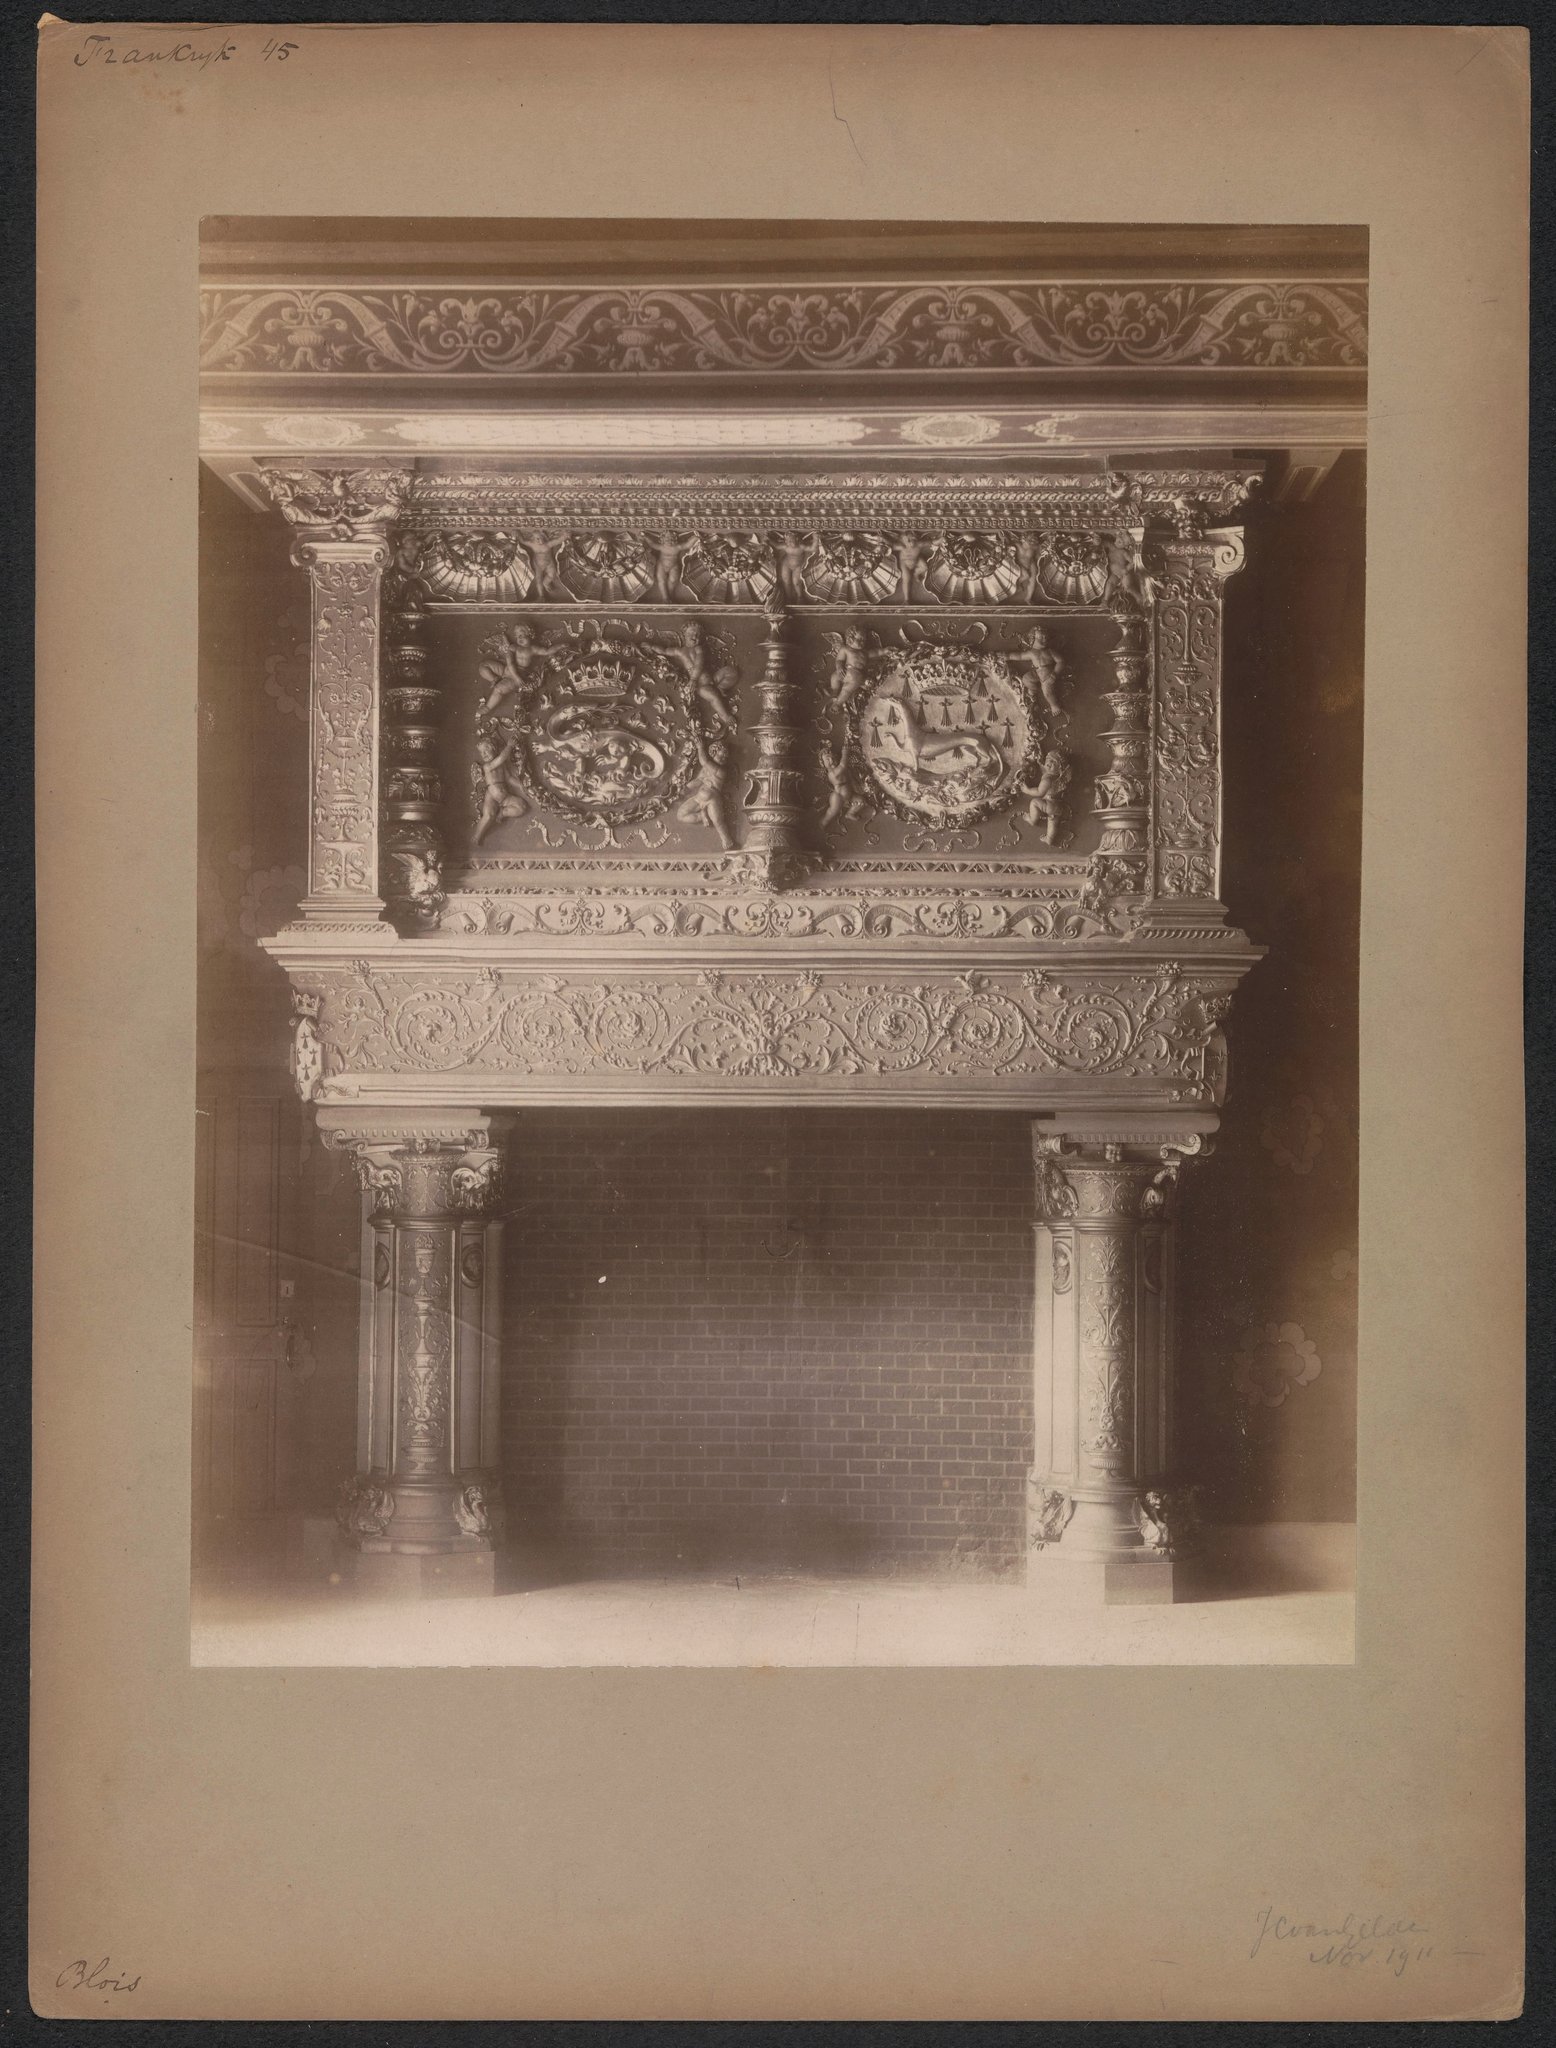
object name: photograph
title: Schoorsteenmantel in het Kasteel van Blois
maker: Anonymous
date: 1850-1900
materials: cardboard, photographic support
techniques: albumen print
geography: blois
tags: chimney-piece, mantelpiece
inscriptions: annotation: ‘Blois’, annotation: ‘JC van Gelde[...]/ Nov. 1911’, collector's mark: ‘[RIJKS NORMAAL]SCHOOL voor T[EEKENONDERWIJZERS] AMSTERDAM’, annotation: ‘Frankrijk 45’, annotation: ‘Blois.’